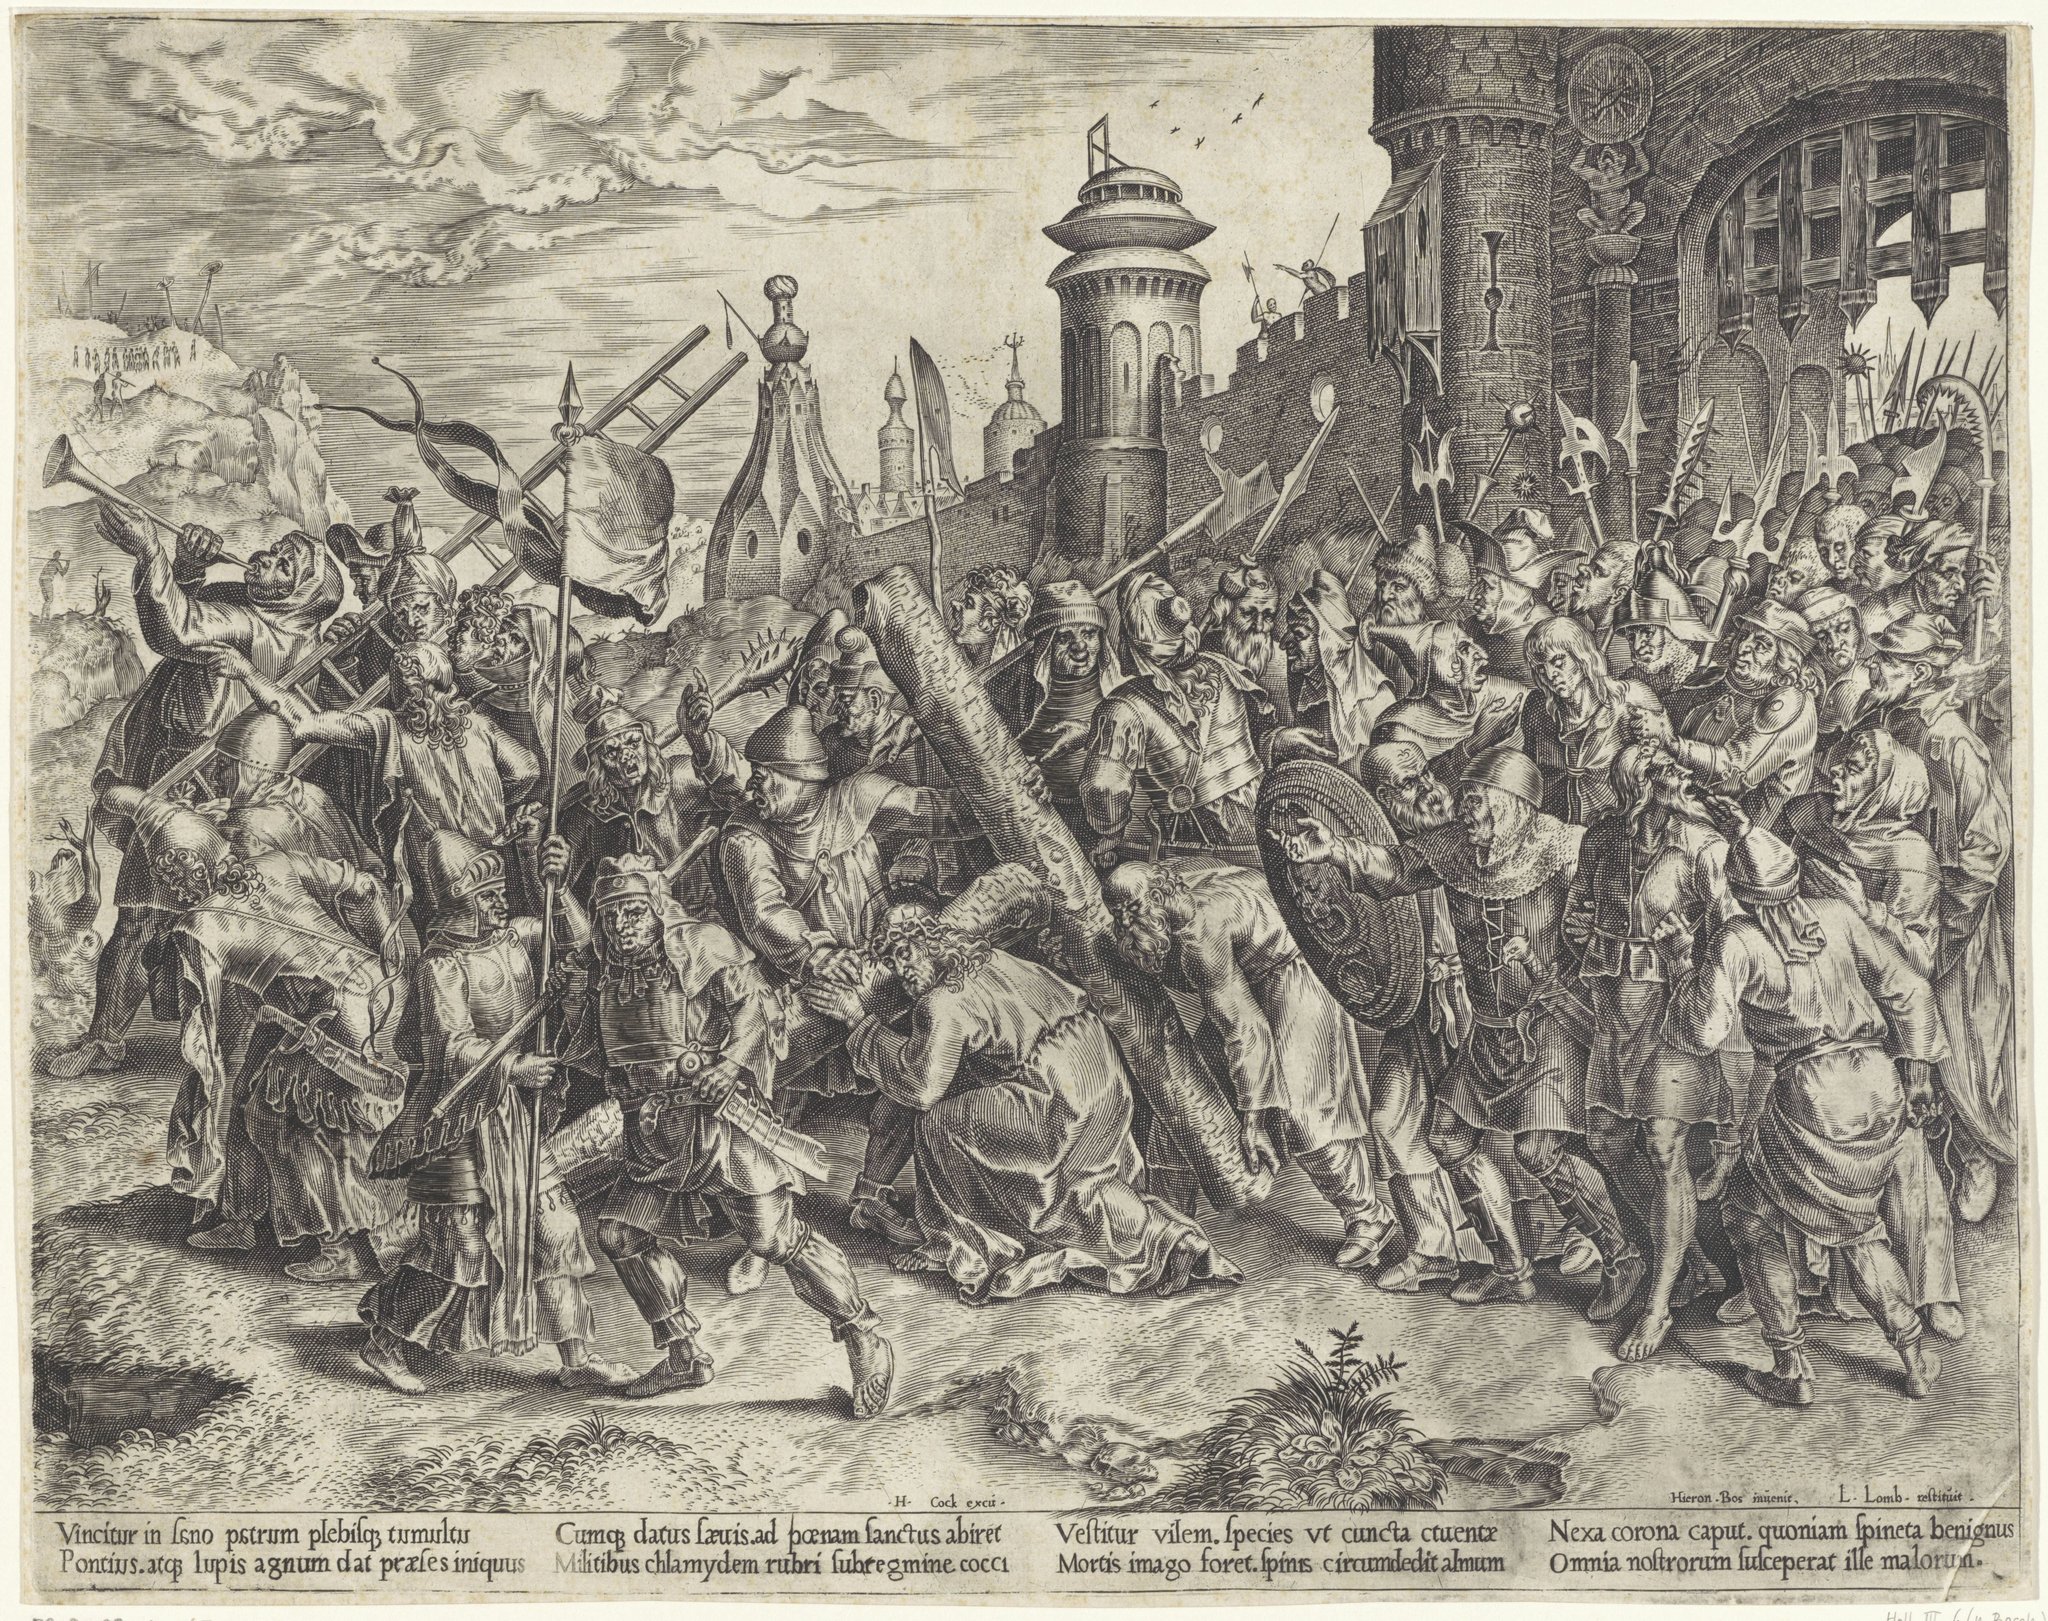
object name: print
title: Kruisdraging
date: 1548-1570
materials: paper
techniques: engraving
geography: liège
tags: carrying of the cross: christ bearing the cross, alone or with the help of others (e.g. simon the cyrenian)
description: Voor een stadspoort draagt Christus het kruis met de hulp van Simon van Cyrene. Ze worden door een grote menigte soldaten gevolgd. Vooraan blaast een man op een bazuin en draagt een andere man een ladder. In de verte staan enkele mensen op Golgota. Onder de voorstelling in de marge een achtregelige toelichting in het Latijn.